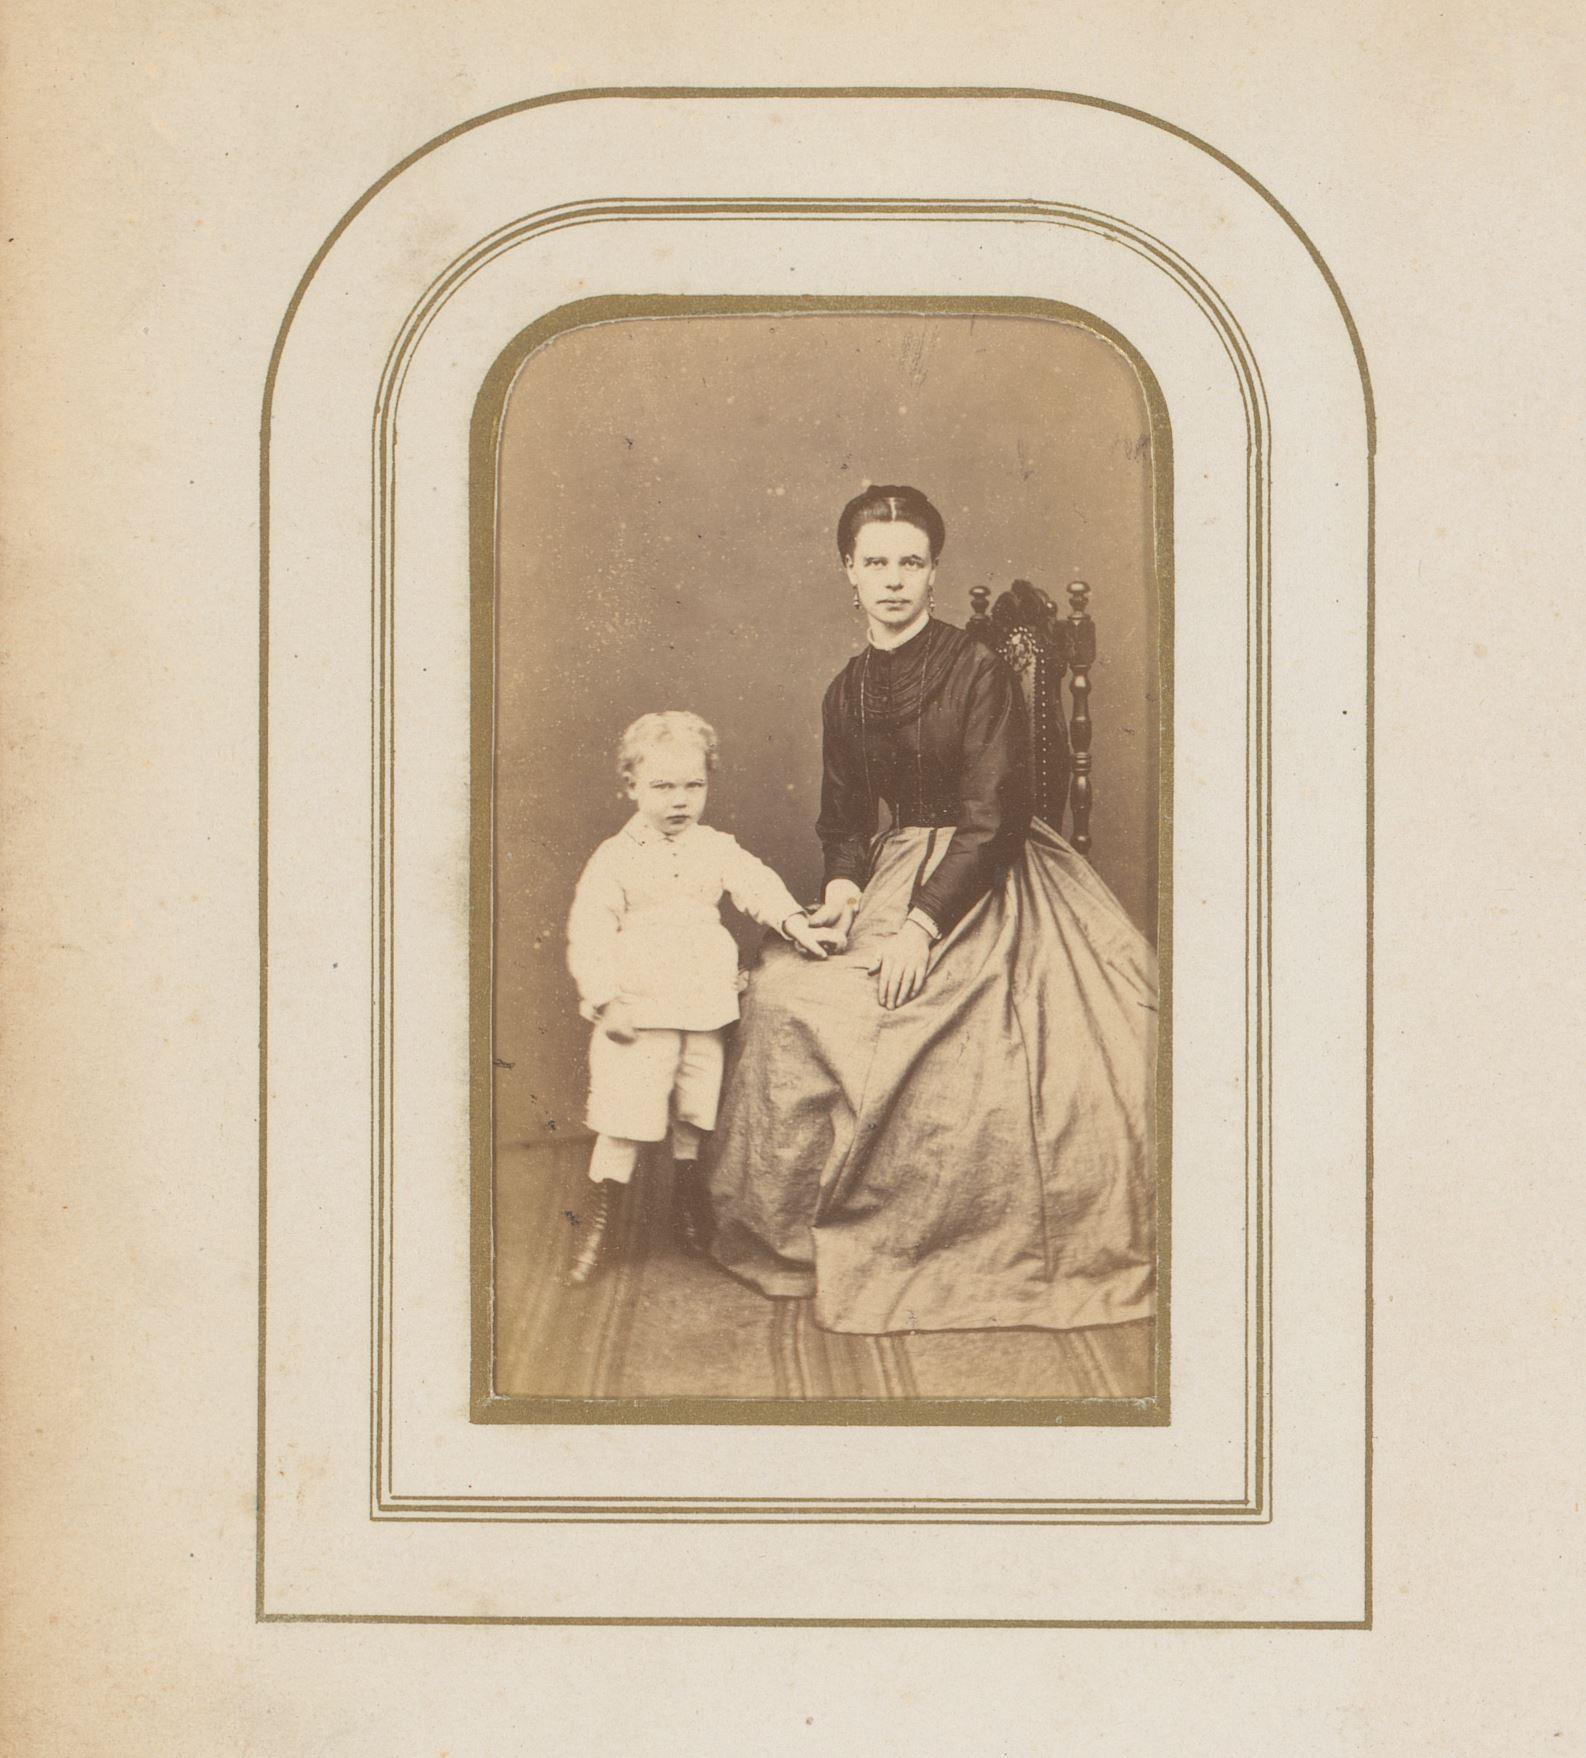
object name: album leaf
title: Portret van een zittende moeder met kind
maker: e. perin jeune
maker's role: fotograaf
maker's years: 1831-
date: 1865-1870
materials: cardboard, photographic support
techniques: albumen print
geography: bergen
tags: sitting figure - aa - female human figure, historical persons - bb - woman, mother and baby or young child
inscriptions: inscription: ‘Photographie Parisienne/ E. Perin Jne/ No 11 Rue Samson/ Mons/ Succursale a Nancy’